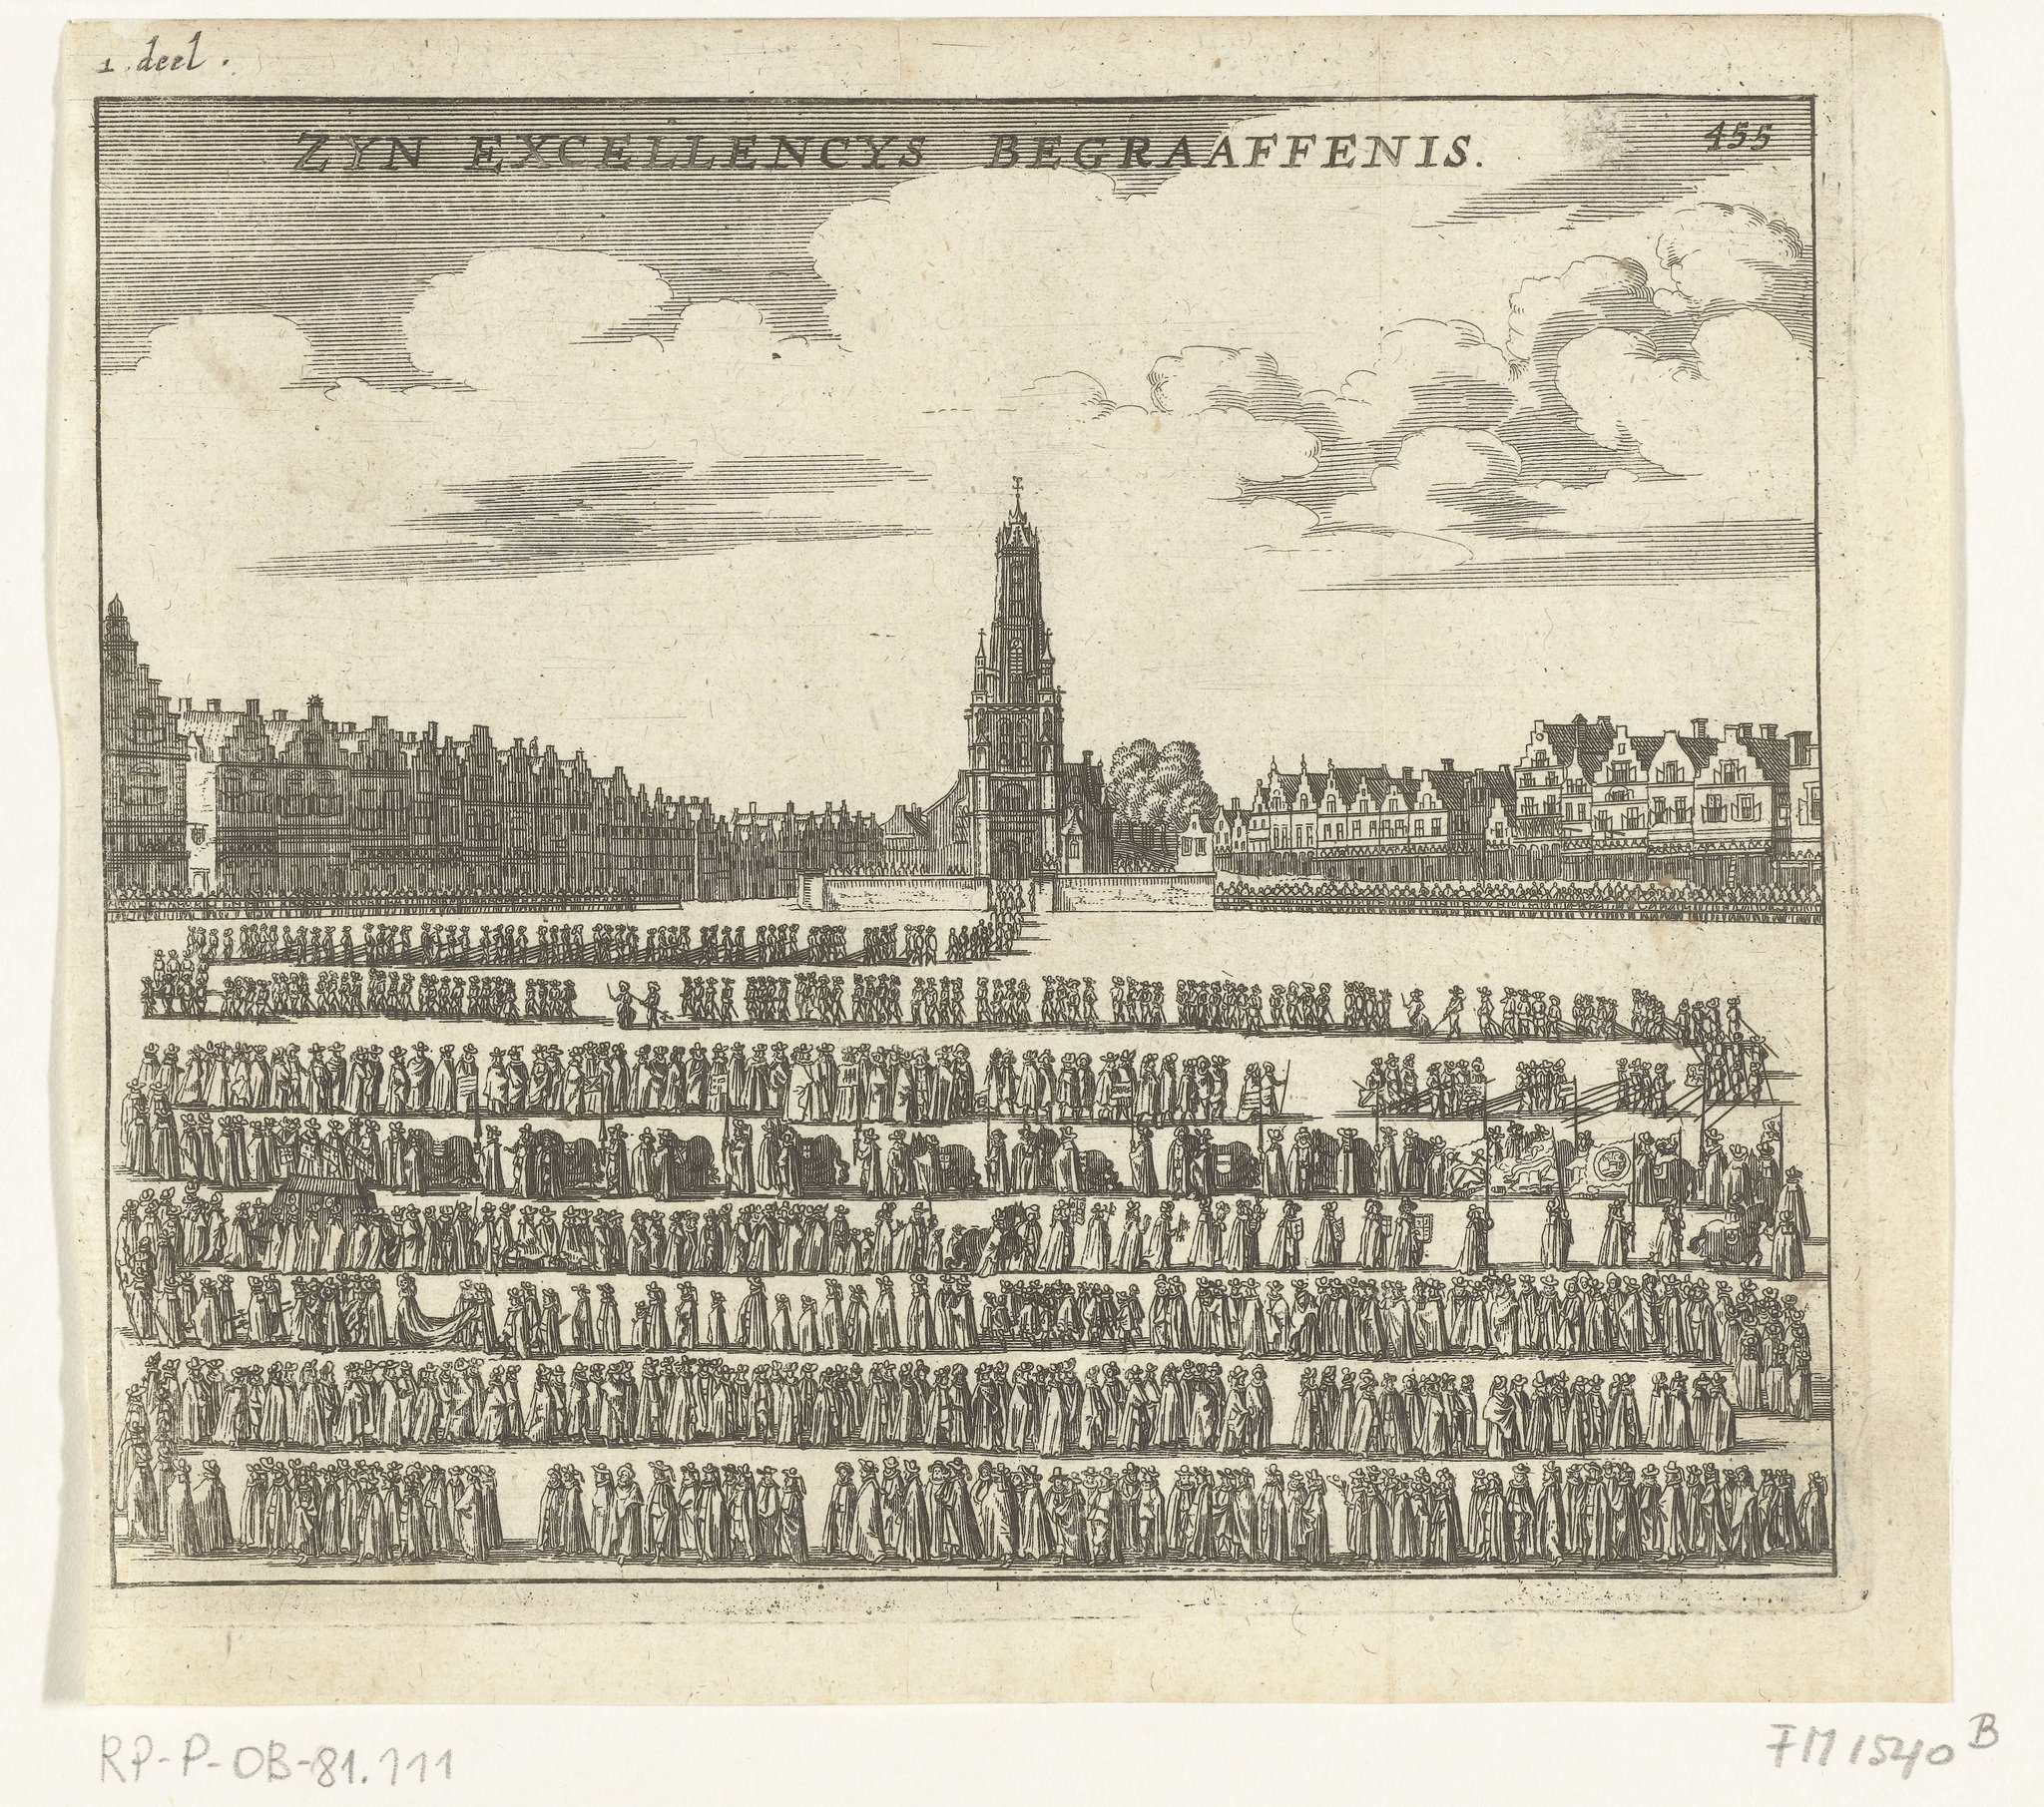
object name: print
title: Zyn Excellencys Begraaffenis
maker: Anonymous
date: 1626-1699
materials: paper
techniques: etching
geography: northern netherlands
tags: the hague, maurice (prince of orange), cortege, funeral procession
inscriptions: collector's mark: Lugt 963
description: De begrafenisstoet van prins Maurits te Delft op 16 september 1625. Een lange stoet slingert zich over de Grote Markt in acht rijen naar de ingang van de Nieuwe Kerk. Vooraan de stoet de schutterijen van de stad Delft. Genummerd: 1. deel / 455.